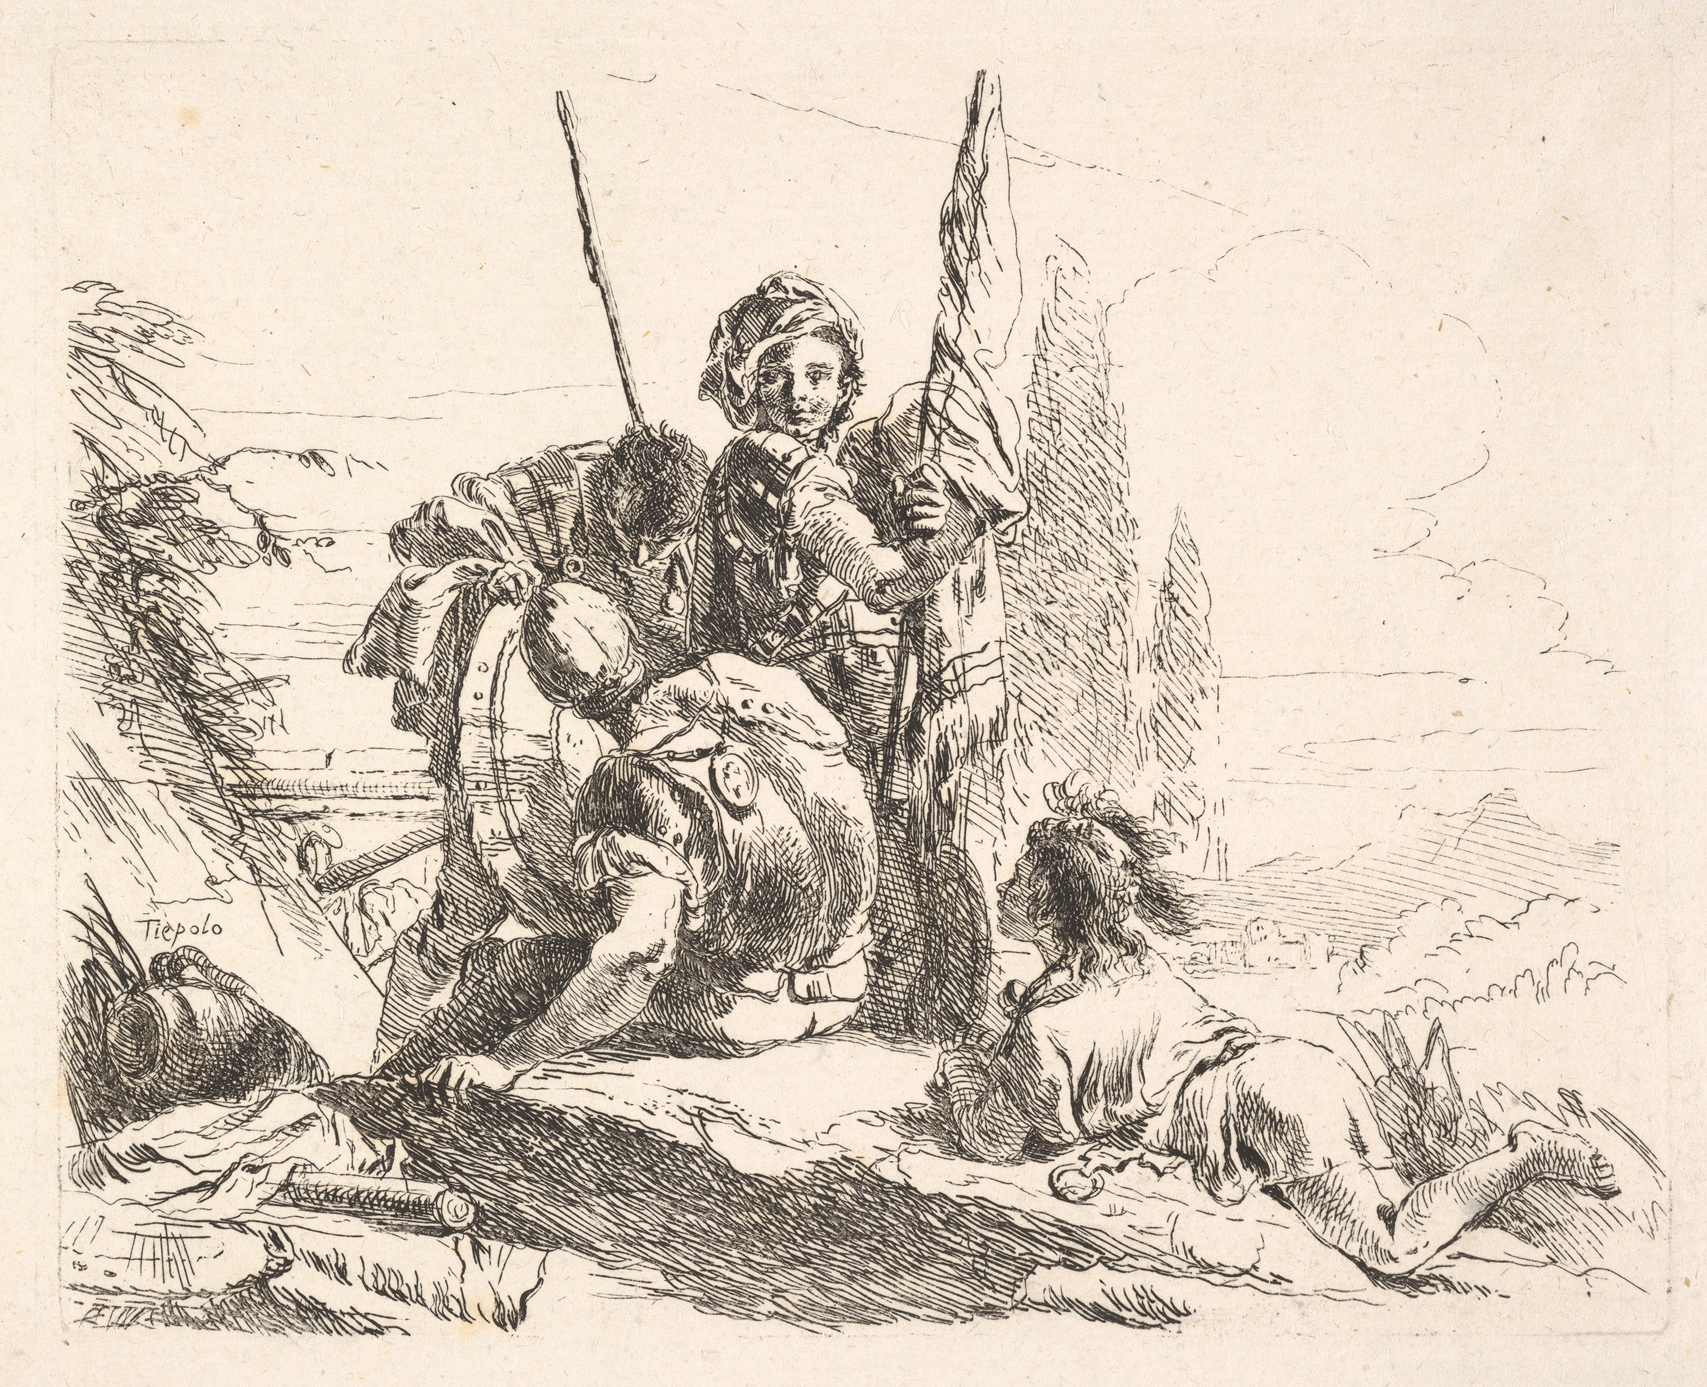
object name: print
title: Three soldiers and a youth lying on his abdomen in a landscape, the soldiers bear armor and a flag, from "The Capricci"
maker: giovanni battista tiepolo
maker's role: artist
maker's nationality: italian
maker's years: 1696-1770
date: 1740-1742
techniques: etching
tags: soldiers,armor,landscapes,flags